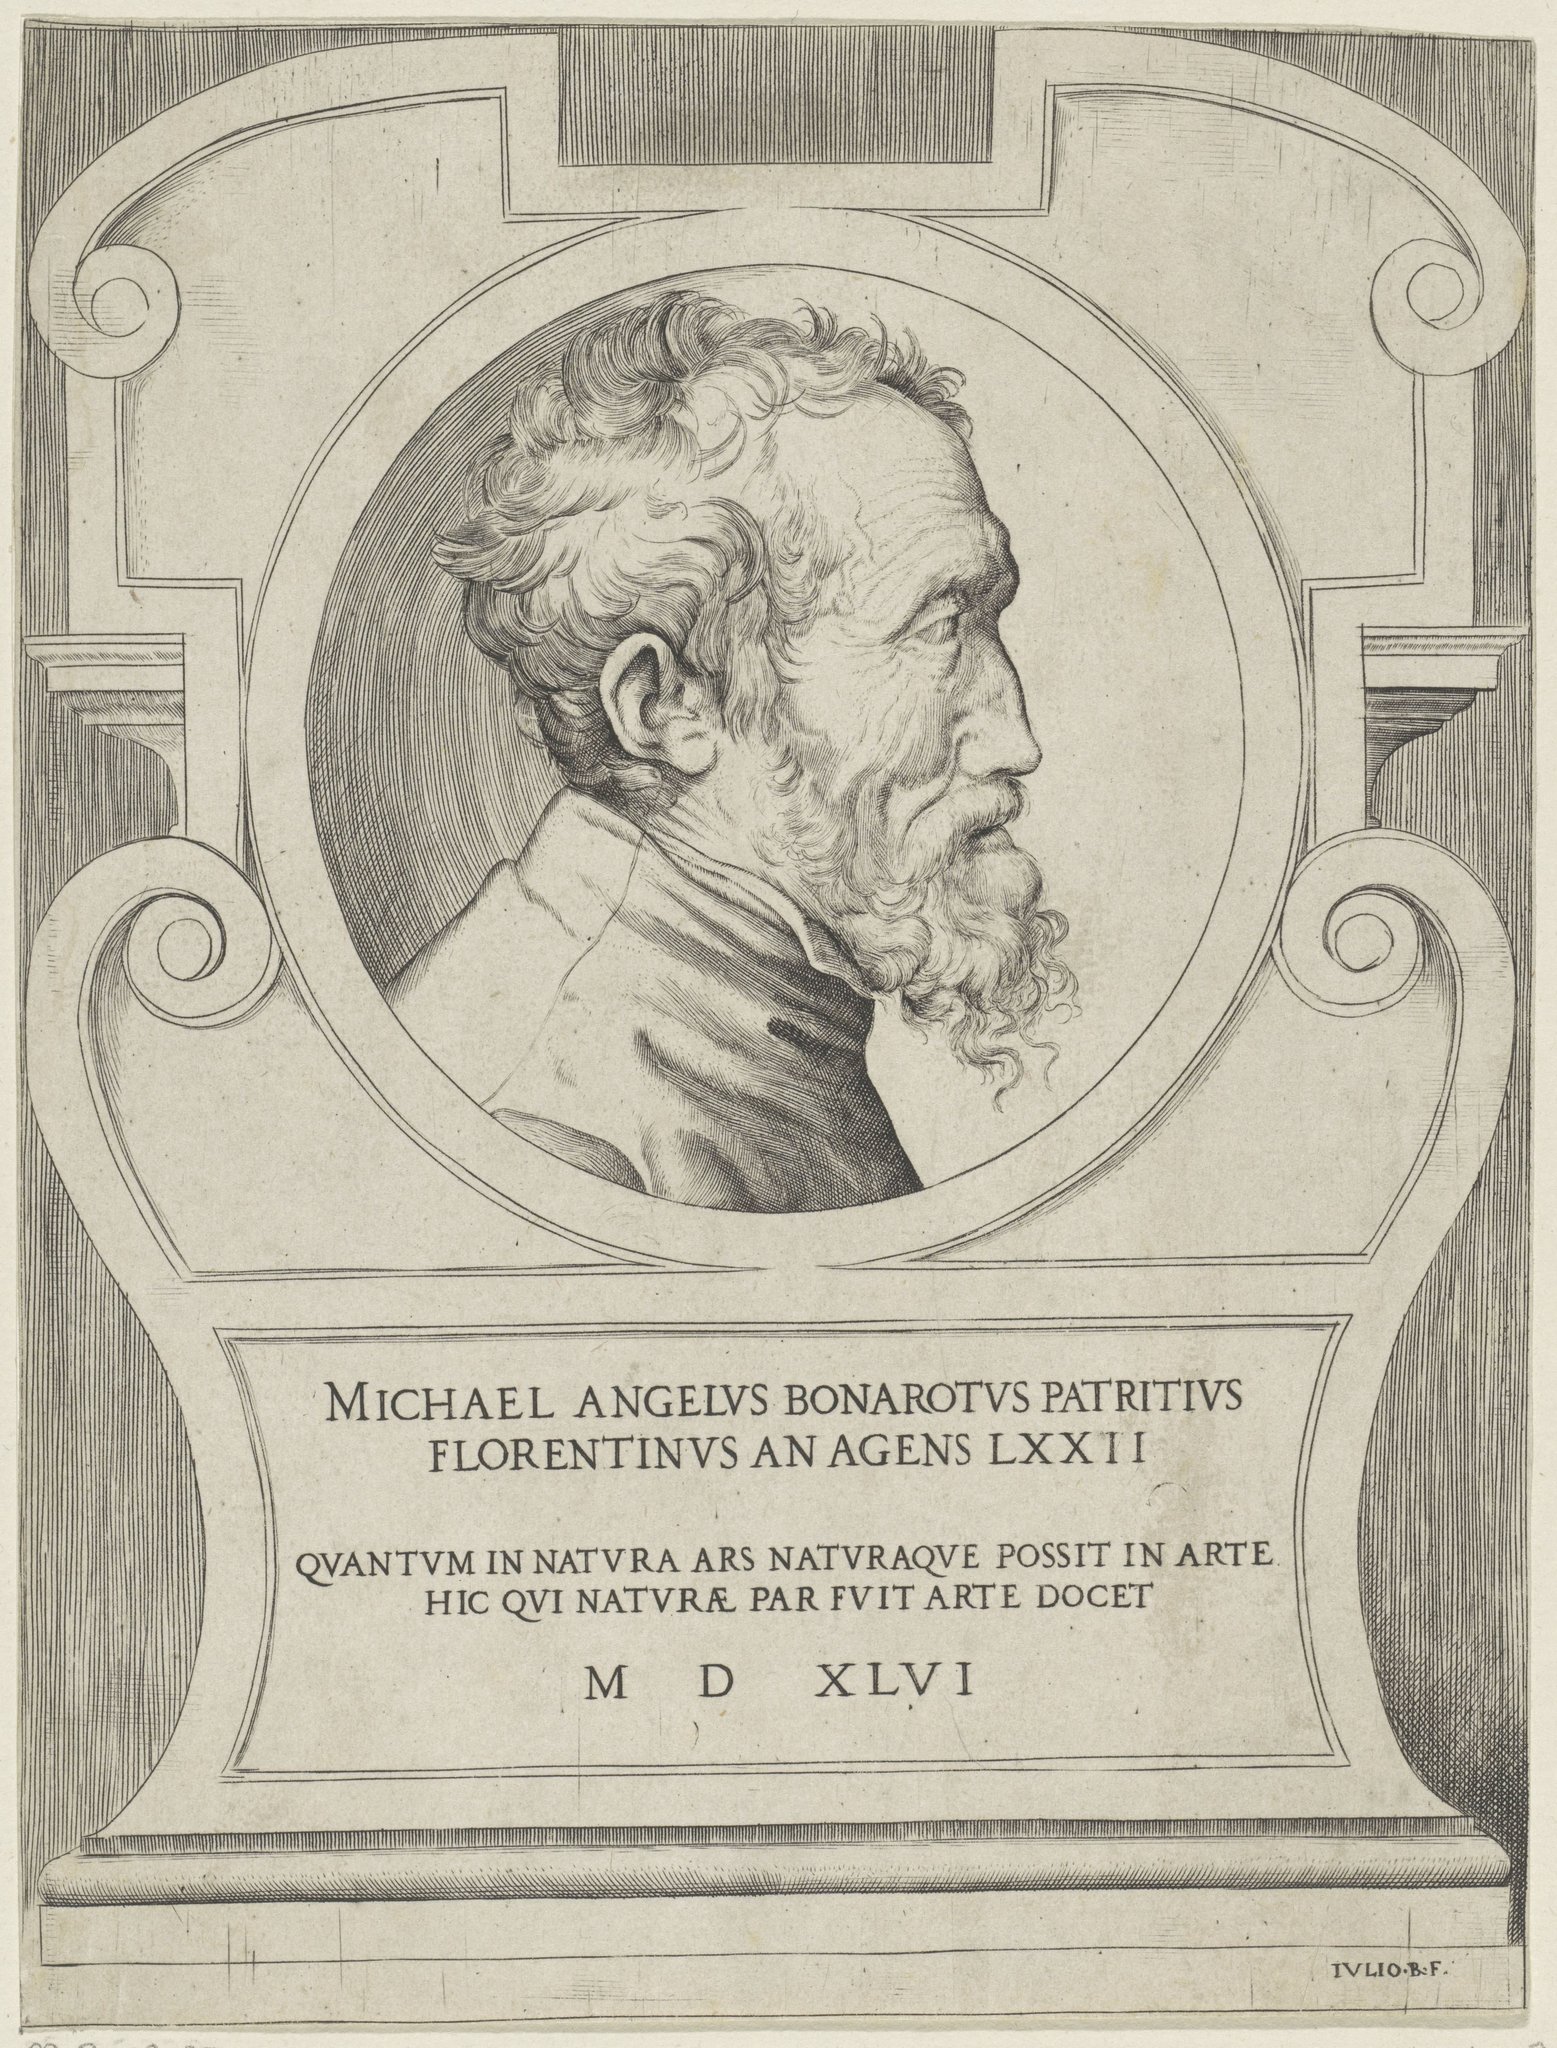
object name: print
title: Portret van de kunstenaar Michelangelo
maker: giulio bonasone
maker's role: painter, print maker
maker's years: 1510-1576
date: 1546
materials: paper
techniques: engraving, etching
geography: italy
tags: rome, painter, draughtsman, sculptor, michelangelo, historical persons, portrait, self-portrait of artist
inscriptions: date